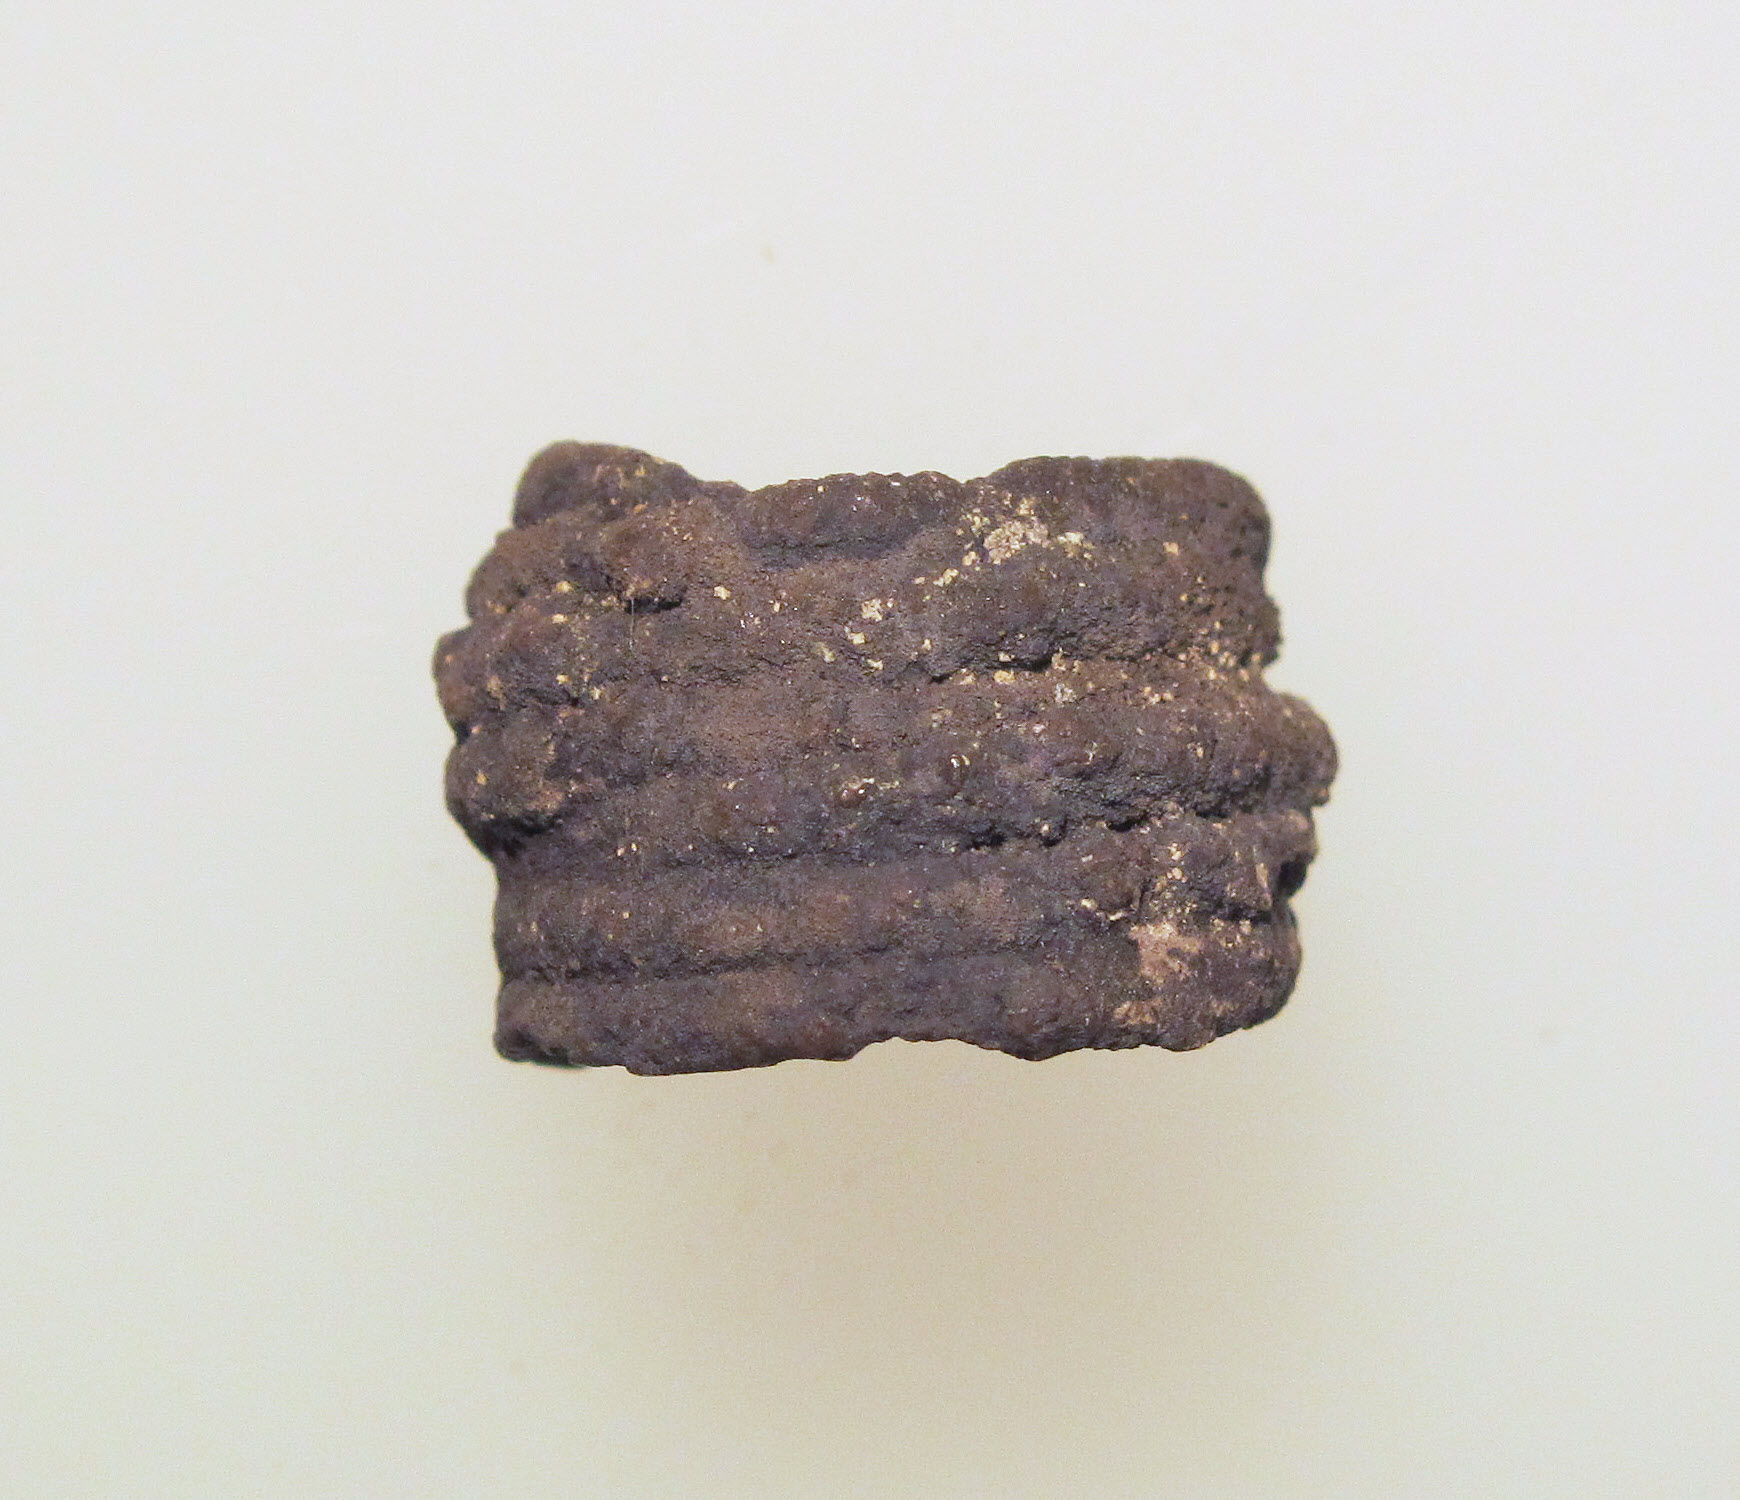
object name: spiral, 6 coil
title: Silver spiral, 6 coils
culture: cypriot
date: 3900 BCE-100 CE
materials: silver